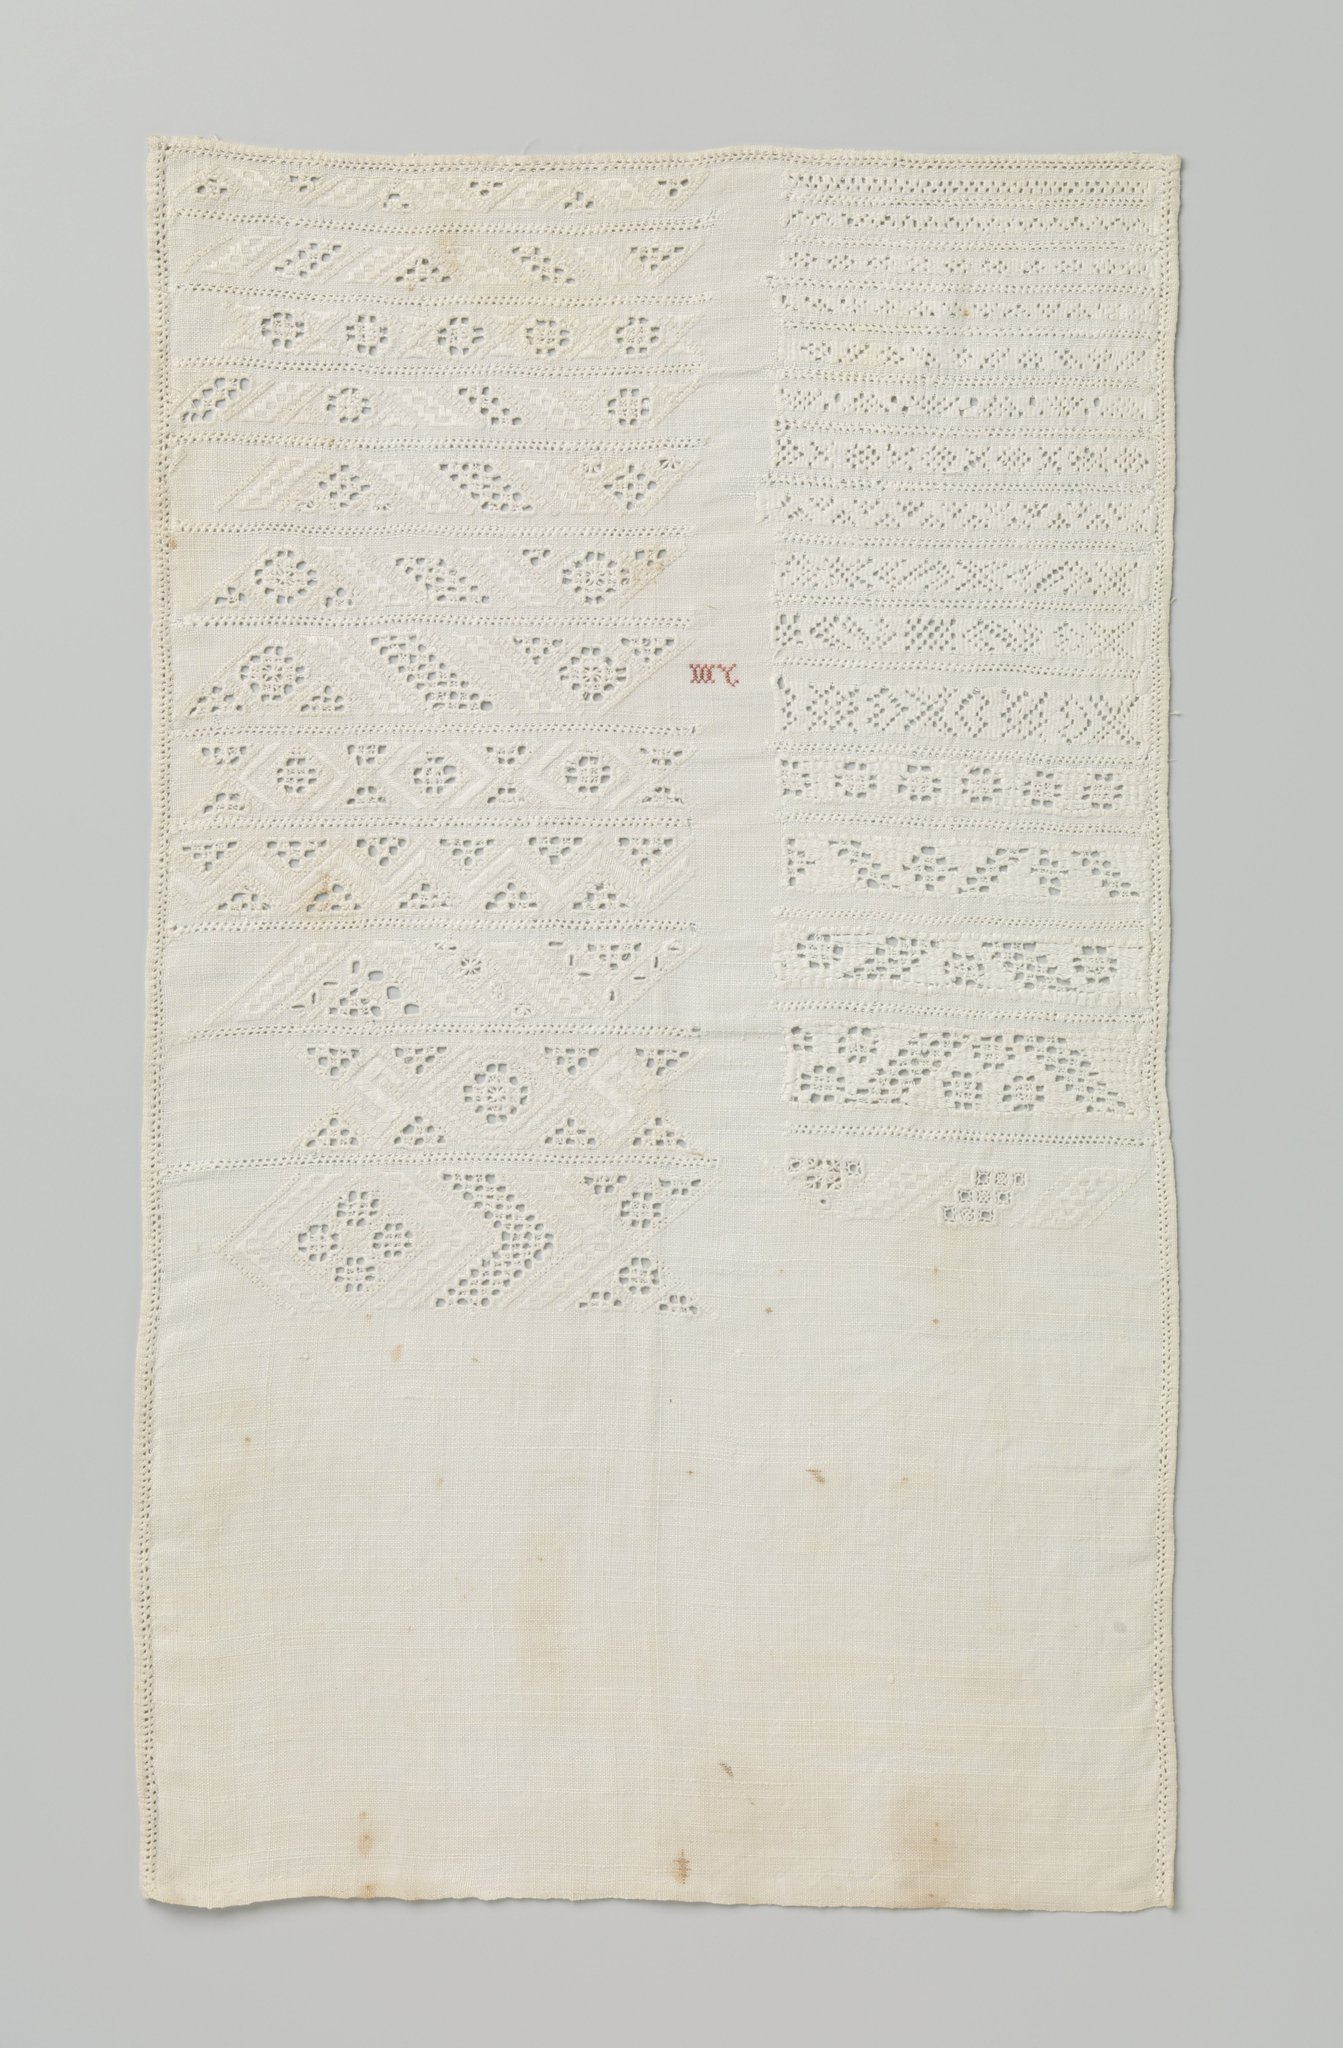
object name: merkdoek, merklap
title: Borduurlap van linnen op linnen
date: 1680-1710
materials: linen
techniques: embroidered, embroidery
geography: north holland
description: Borduurlap van wit linnen op wit linnen. Het borduurwerk heeft randen met verschillende steken en patronen en de initialen MB.